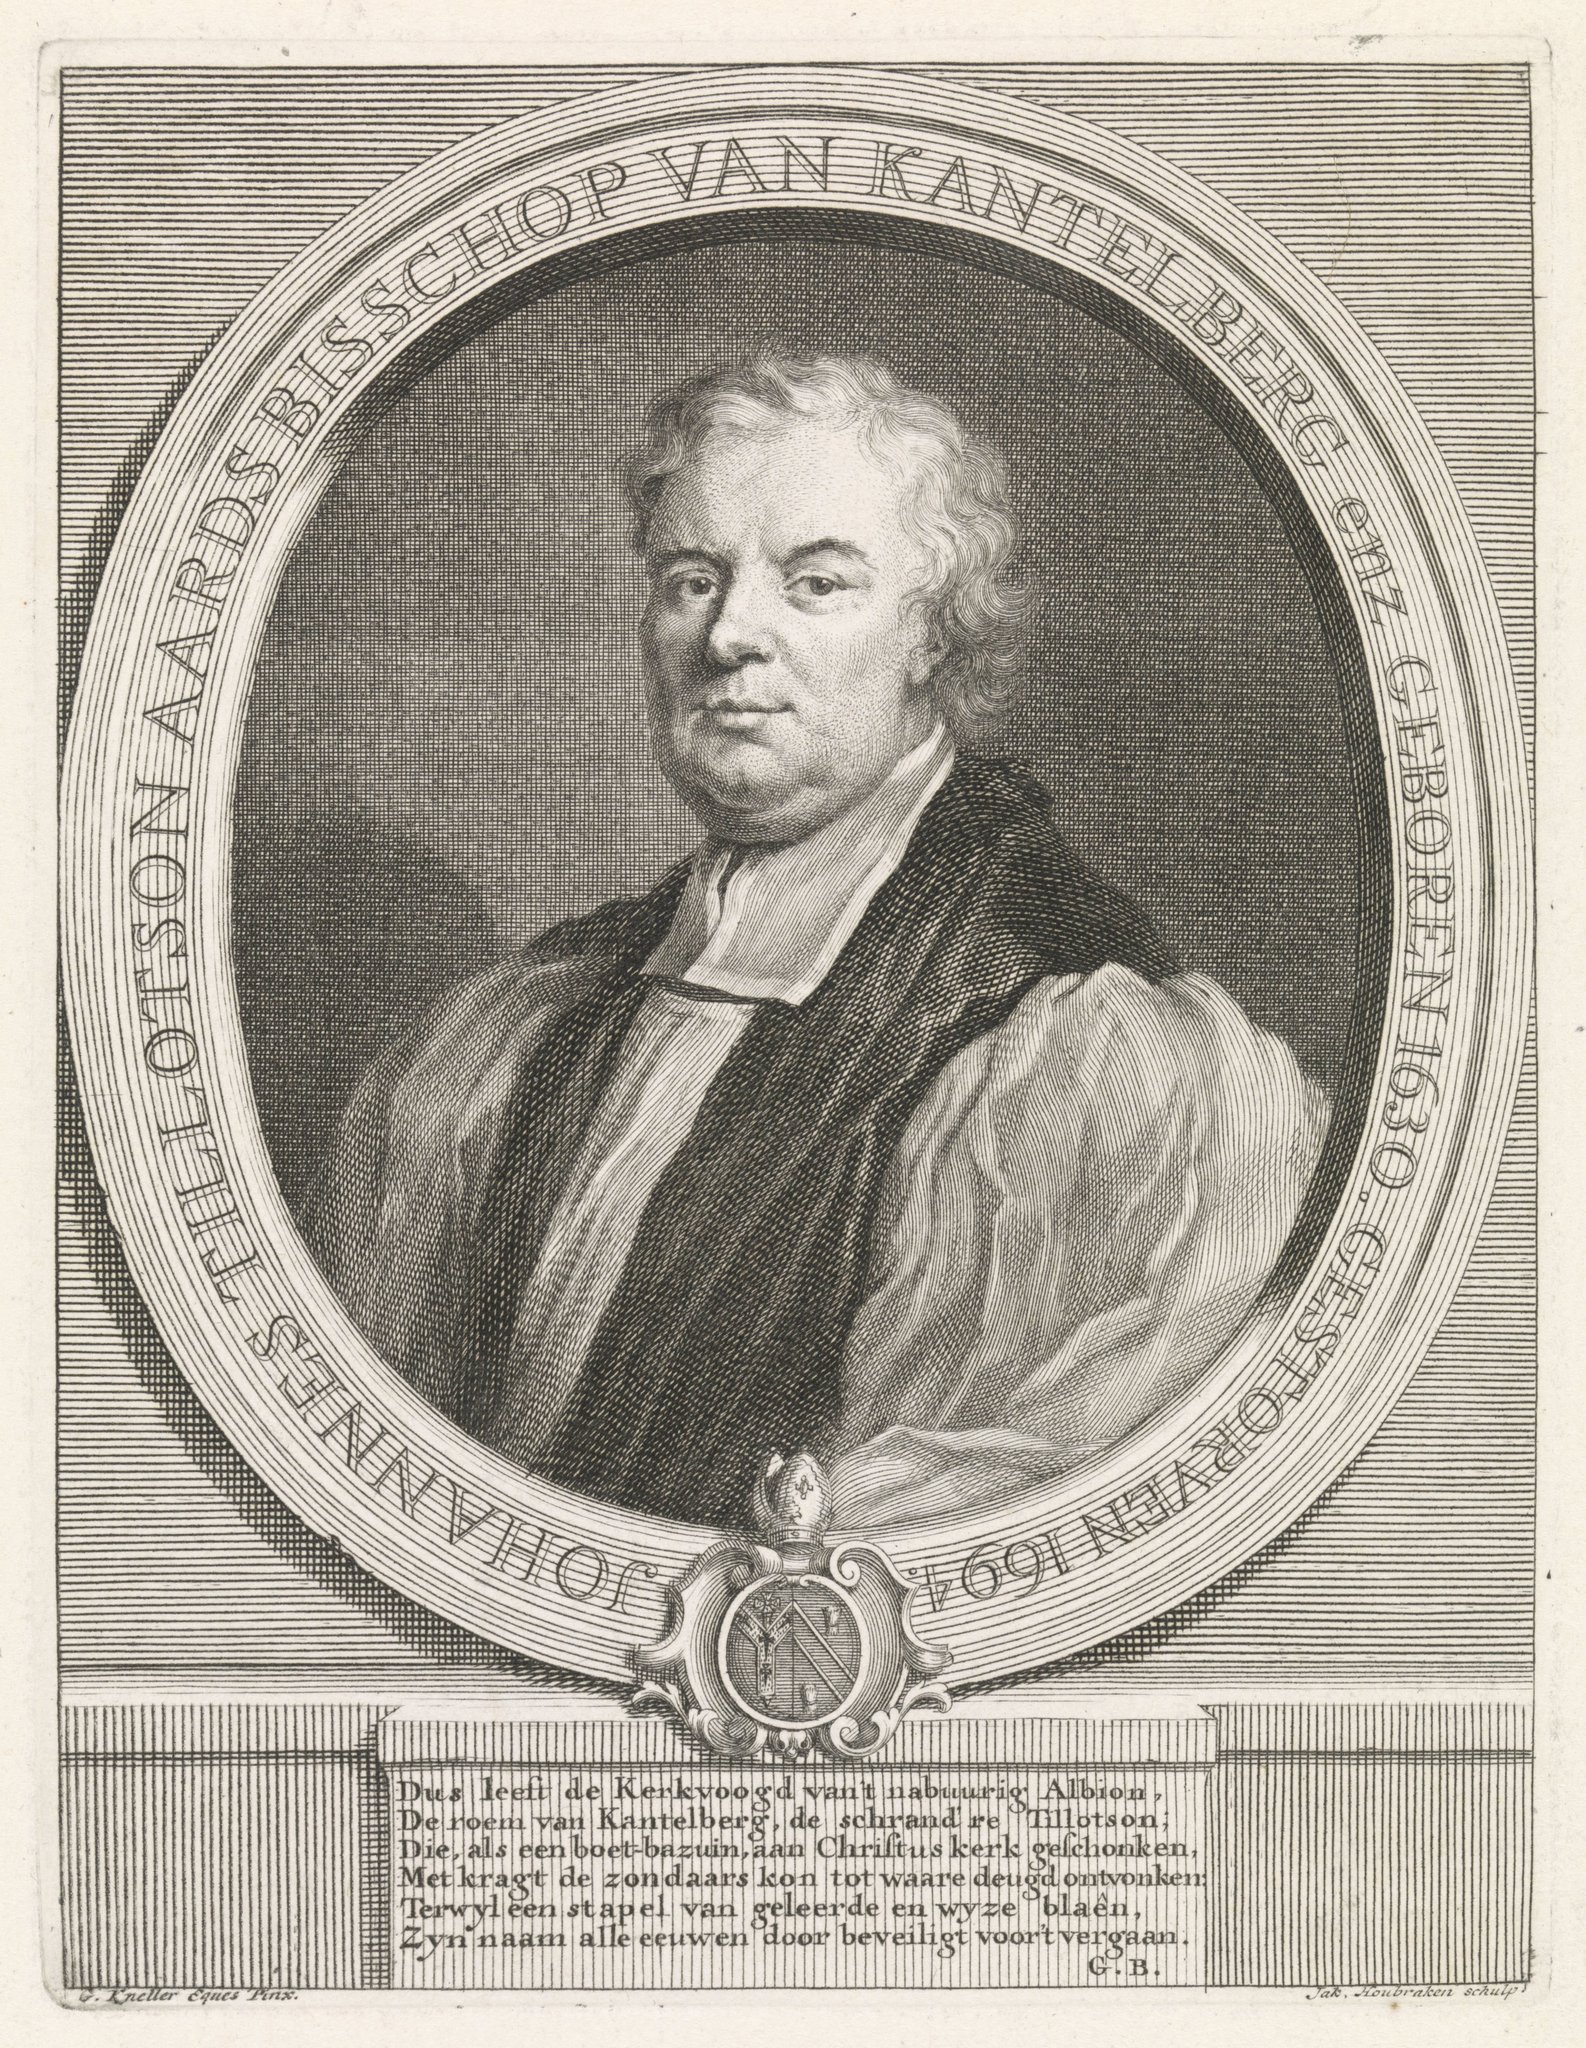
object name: print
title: Portret van John Tillotson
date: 1708-1766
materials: paper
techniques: engraving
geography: amsterdam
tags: clergyman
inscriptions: collector's mark: Lugt 2233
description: Buste naar links van John Tillotson, aartsbisschop van Canterbury, in een ovaal met randschrift in het Nederlands en met onderaan zijn wapen. Het portret rust op een richel waarop een zesregelig vers in het Nederlands.